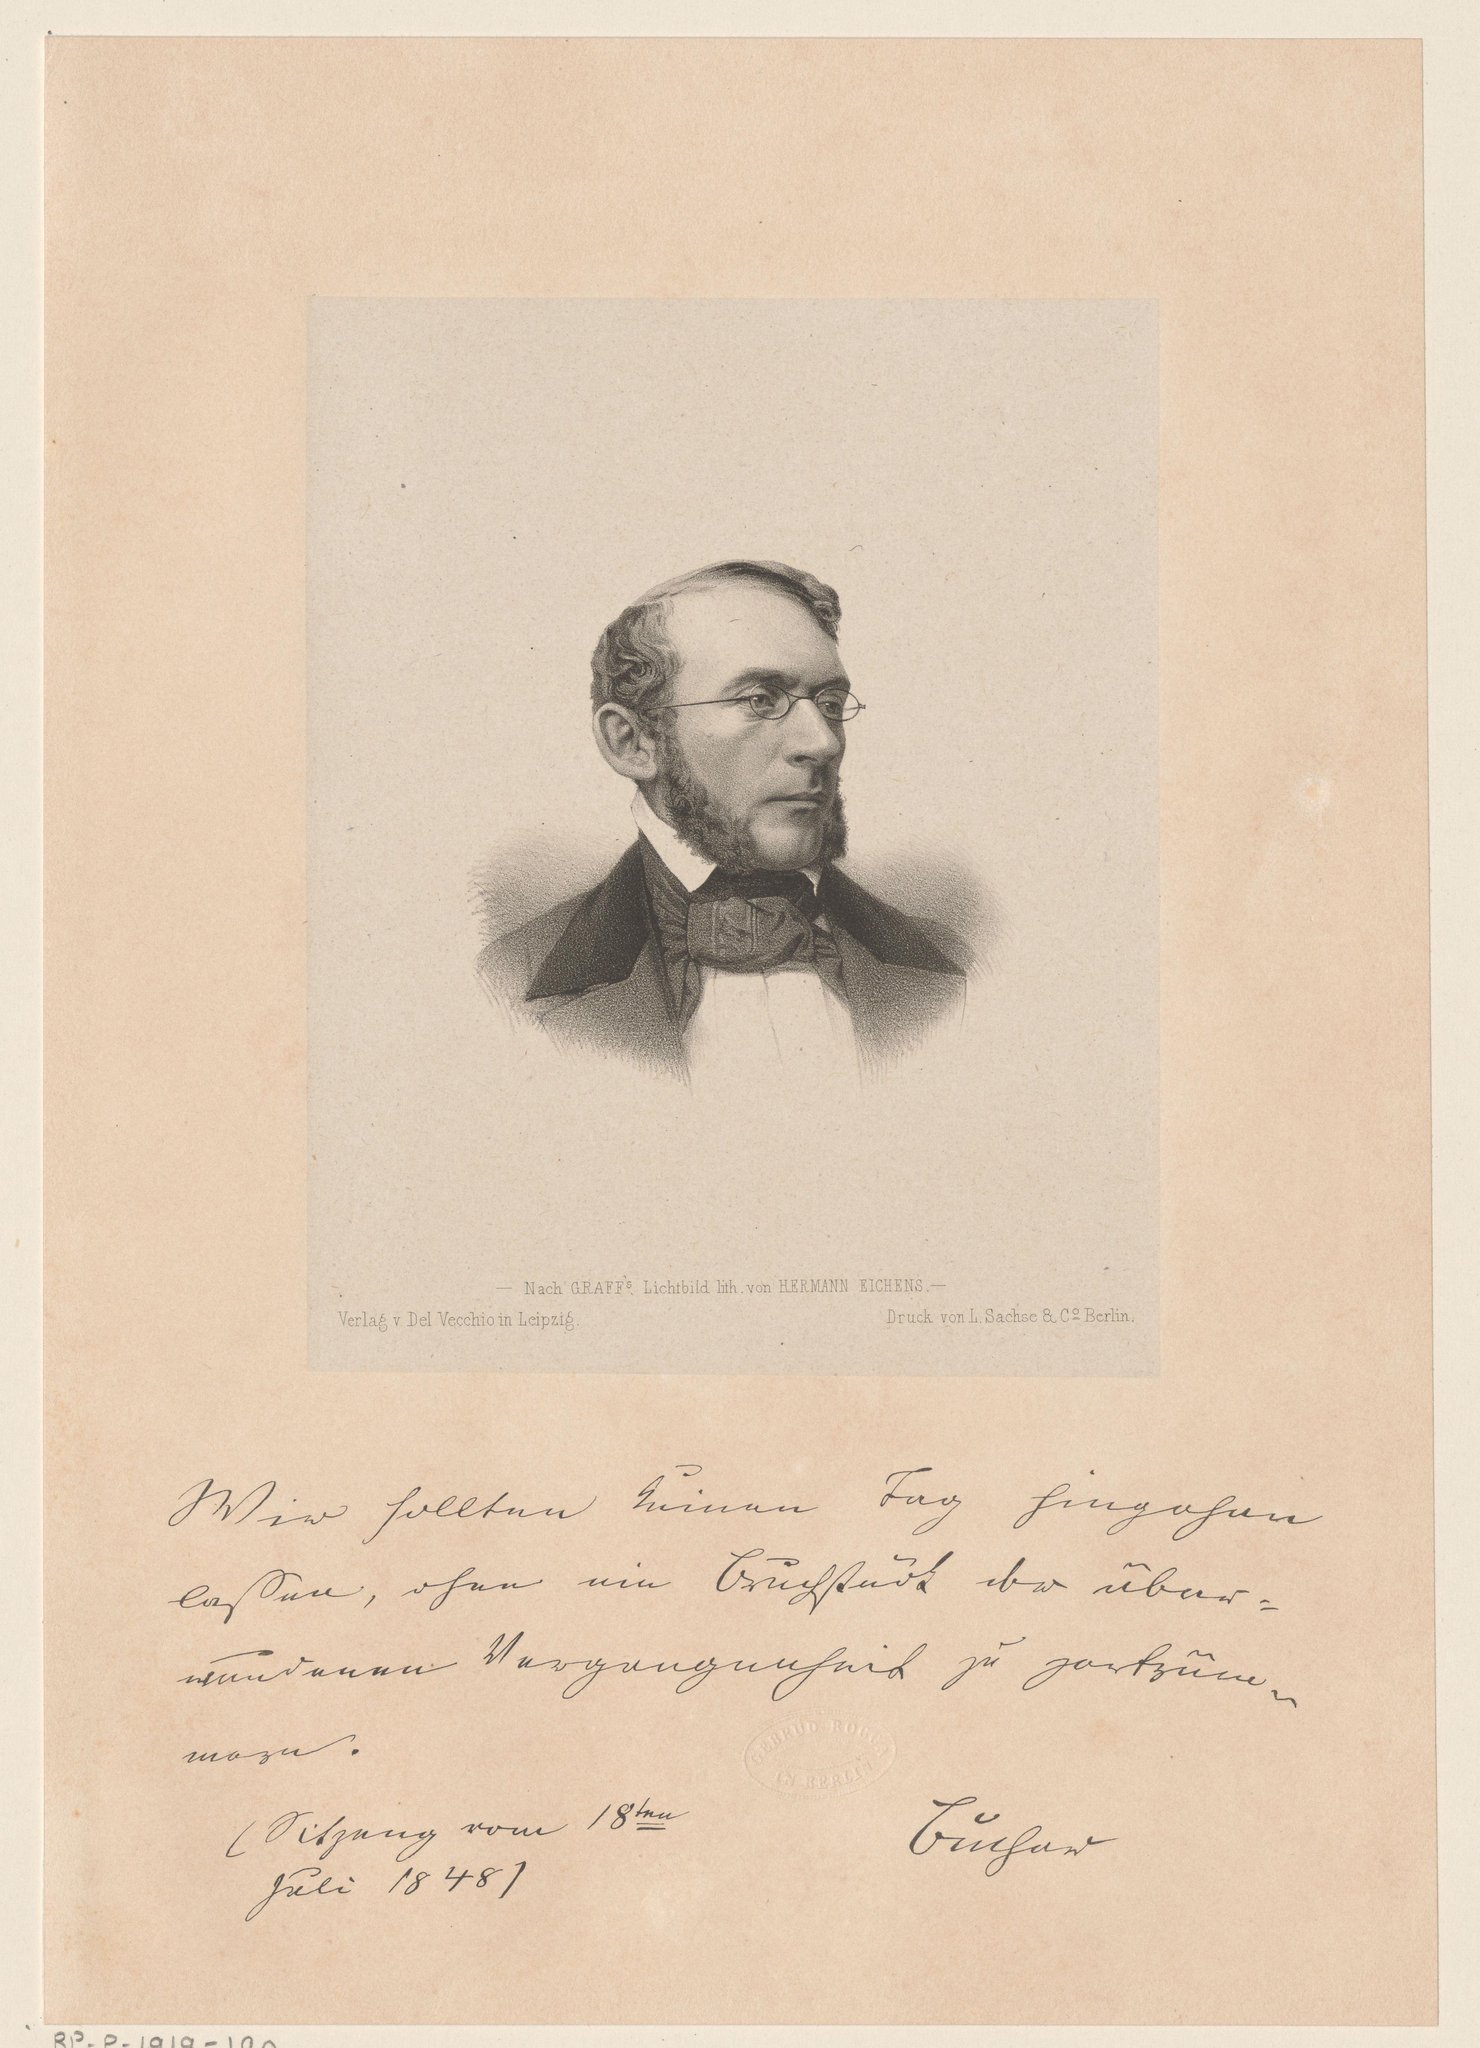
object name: print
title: Portret van Lothar Bucher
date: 1848-1854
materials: paper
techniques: lithograph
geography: berlin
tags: historical persons, portrait of a writer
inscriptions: workshop stamp: Lugt 2141c, collector's mark: Lugt 2228